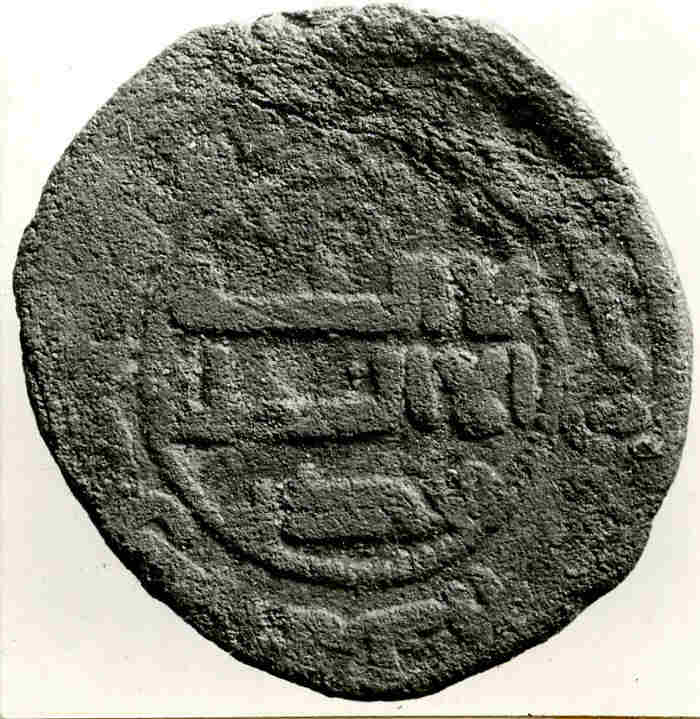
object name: coin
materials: copper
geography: iran